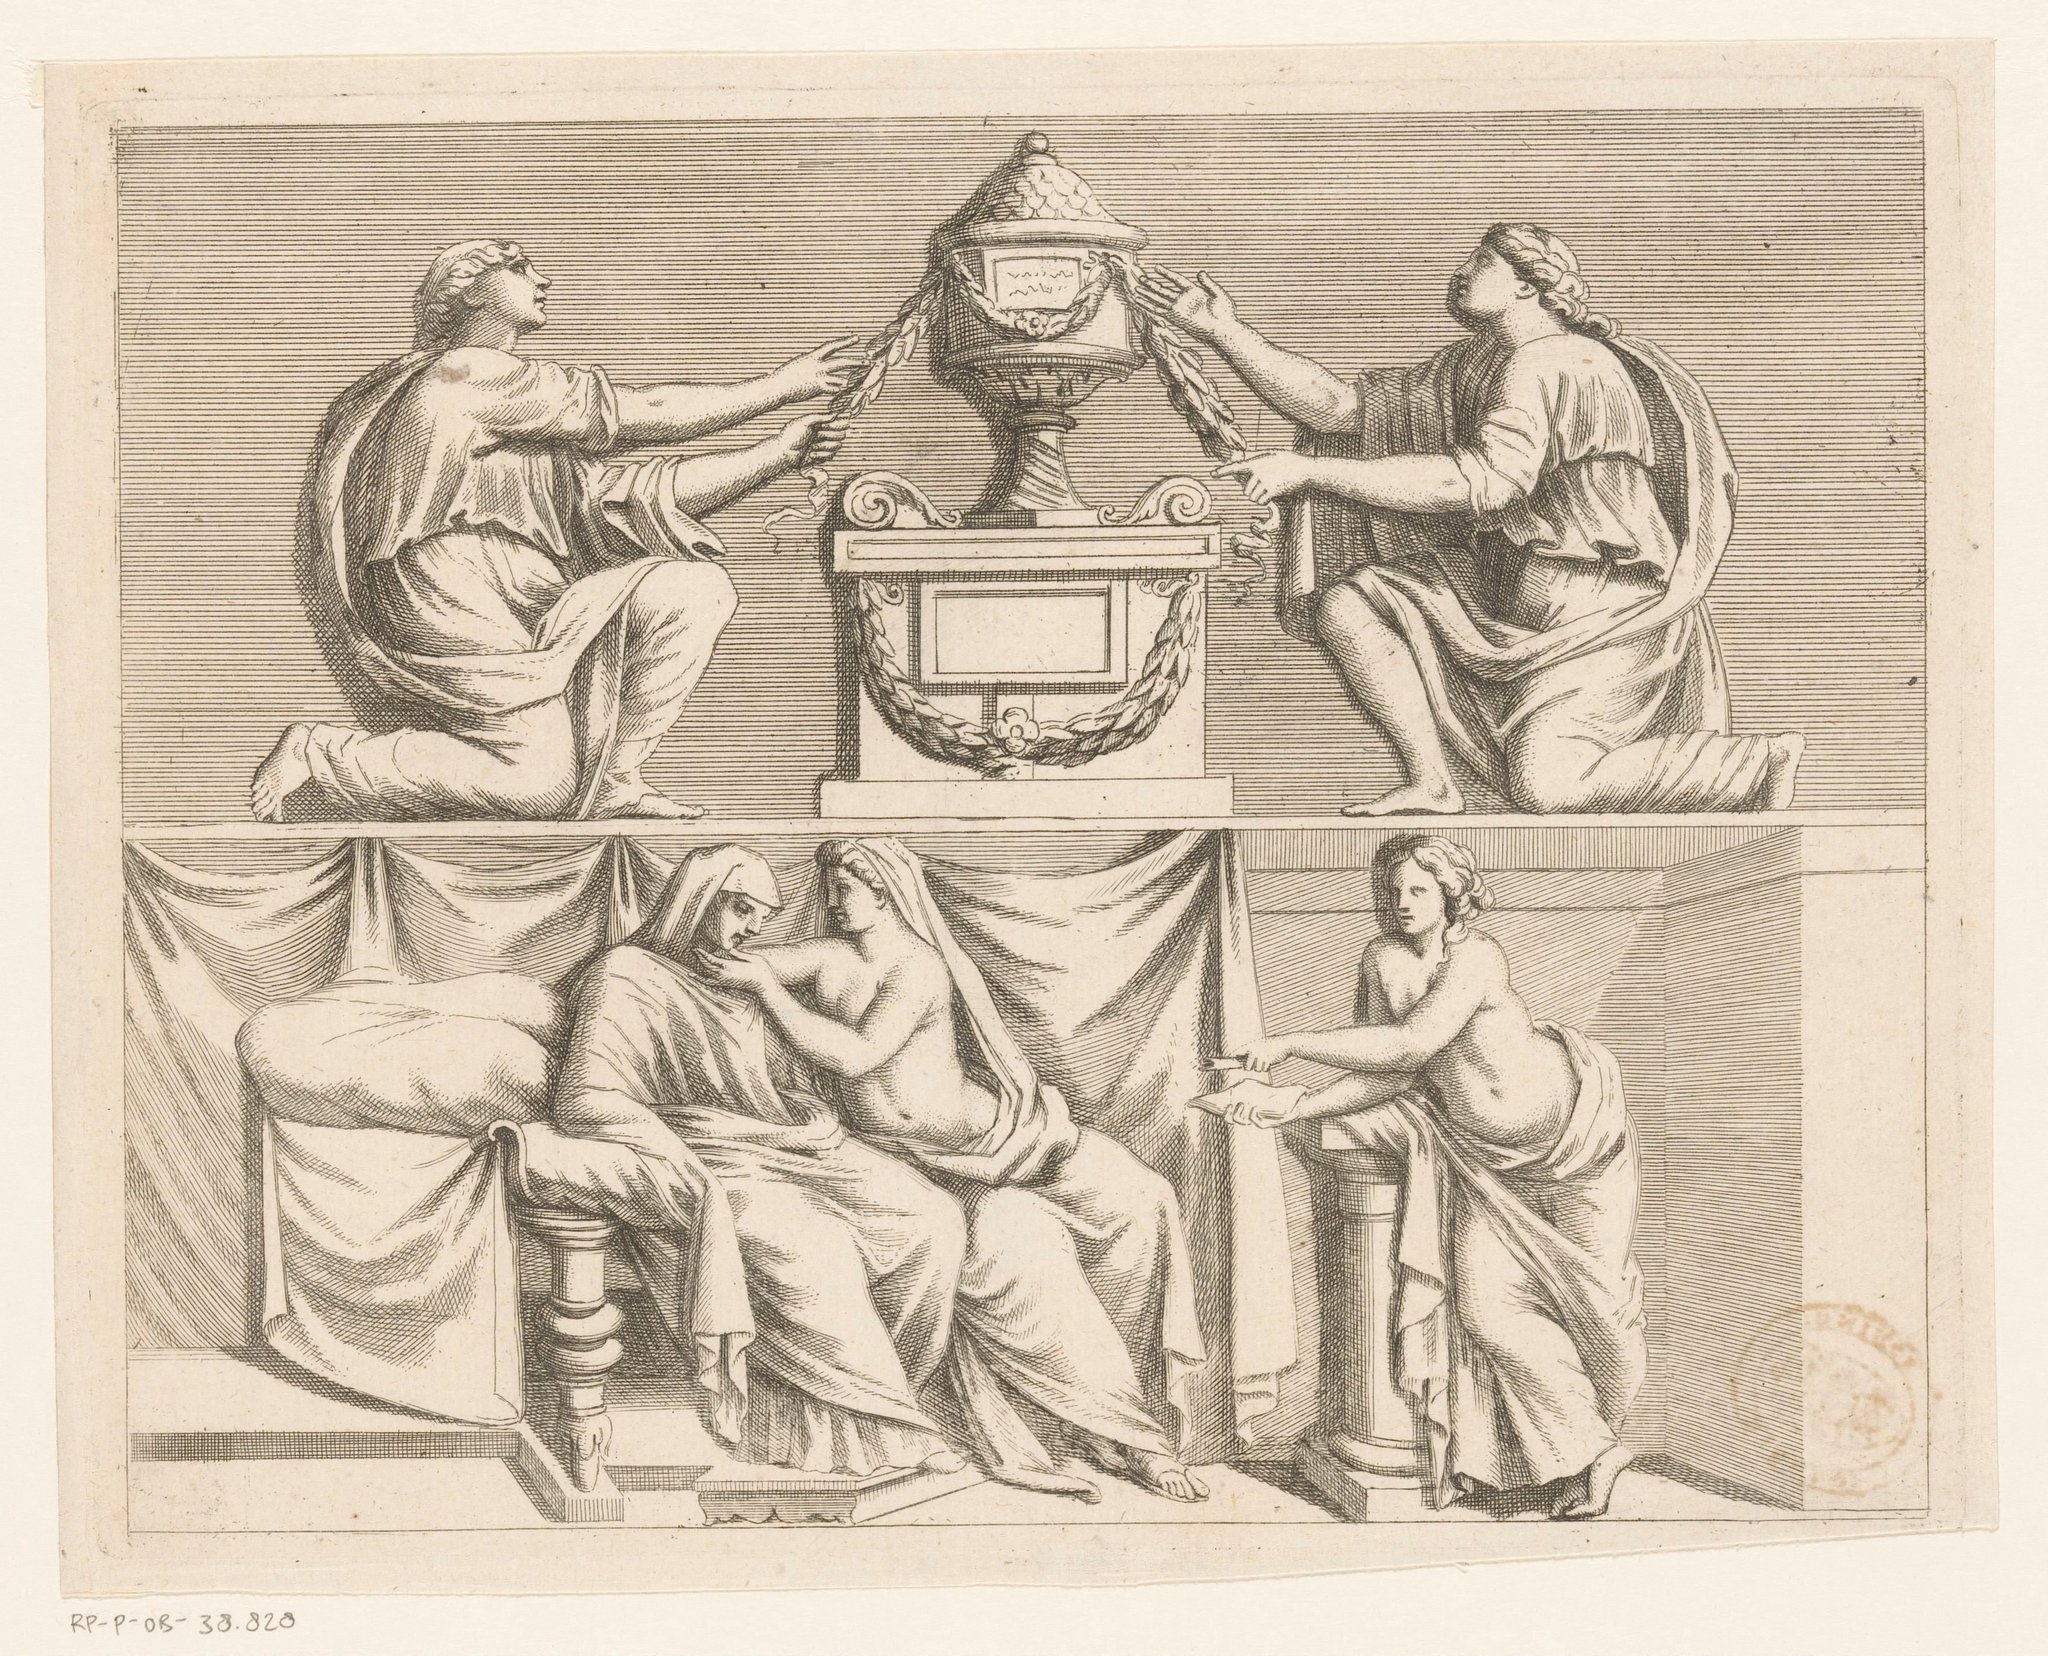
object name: print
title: Huwelijk van Perseus en Andromeda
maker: battista angolo del moro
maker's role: print maker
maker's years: 1514-1575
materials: paper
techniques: etching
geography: italy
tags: perseus and andromeda married by cepheus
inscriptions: collector's mark: Lugt 2228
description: Deze prent maakt onderdeel uit van een reeks van onbekende omvang met scènes uit het leven van Perseus.